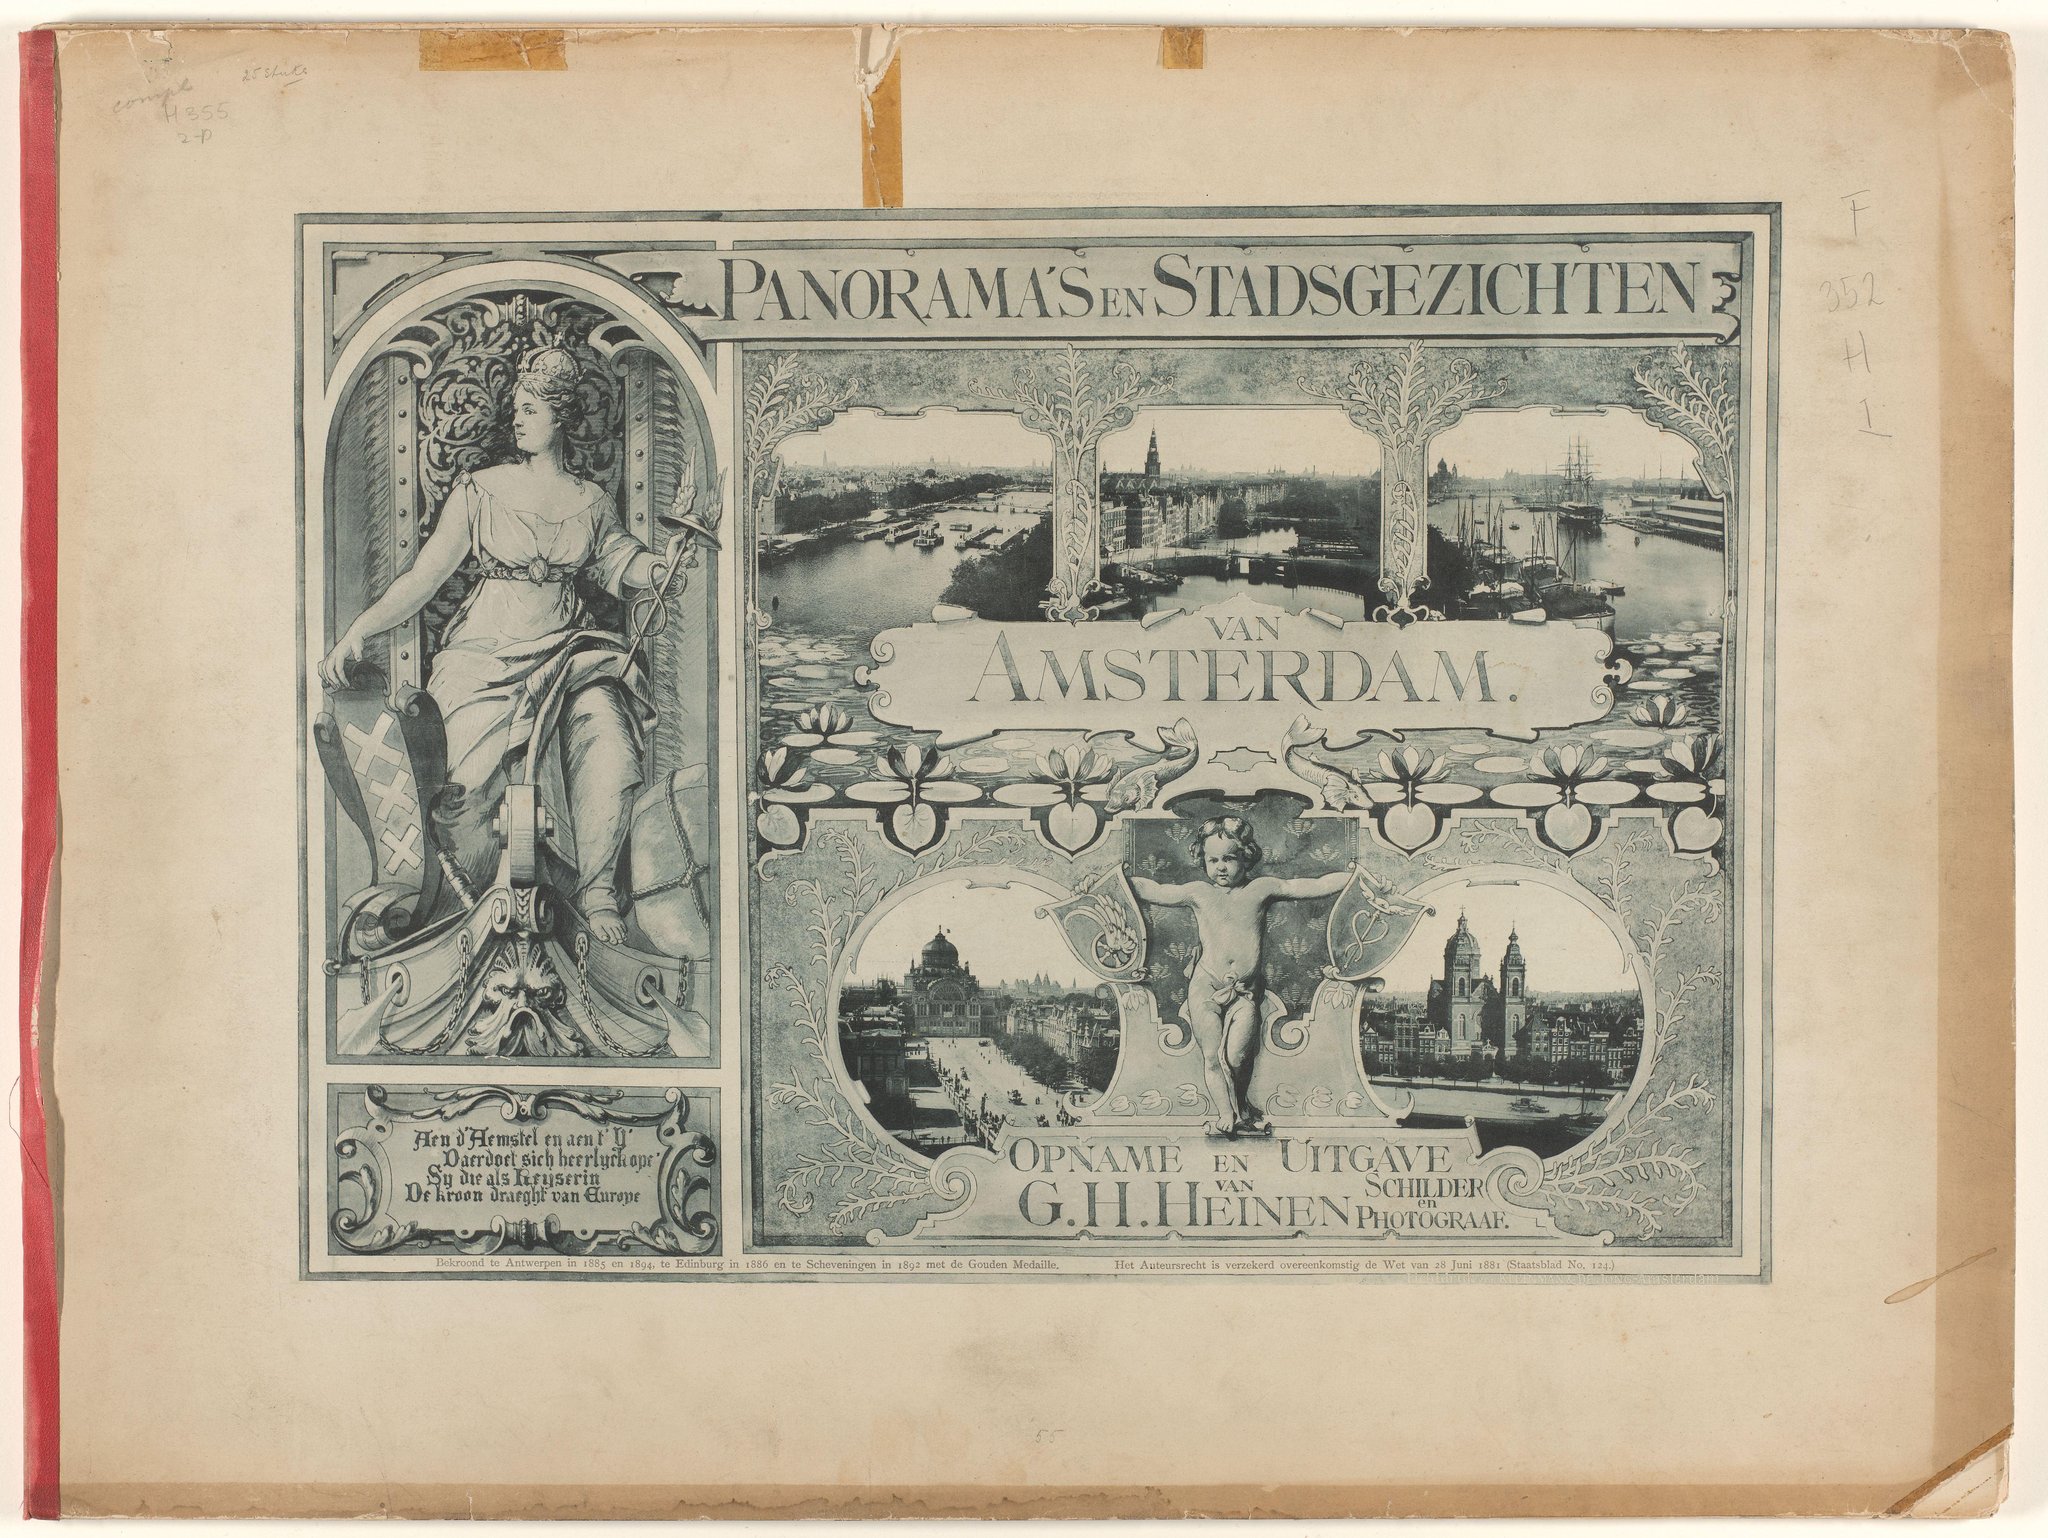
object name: wrapper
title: Panorama's en stadsgezichten van Amsterdam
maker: gerrit hendricus heinen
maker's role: painter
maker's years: 1851-1930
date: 1894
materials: paper, textile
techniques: photograph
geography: amsterdam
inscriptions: inscription: ‘compl. 25 stuks’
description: Omslag met achttien lichtdrukken met stadsgezichten van Amsterdam.